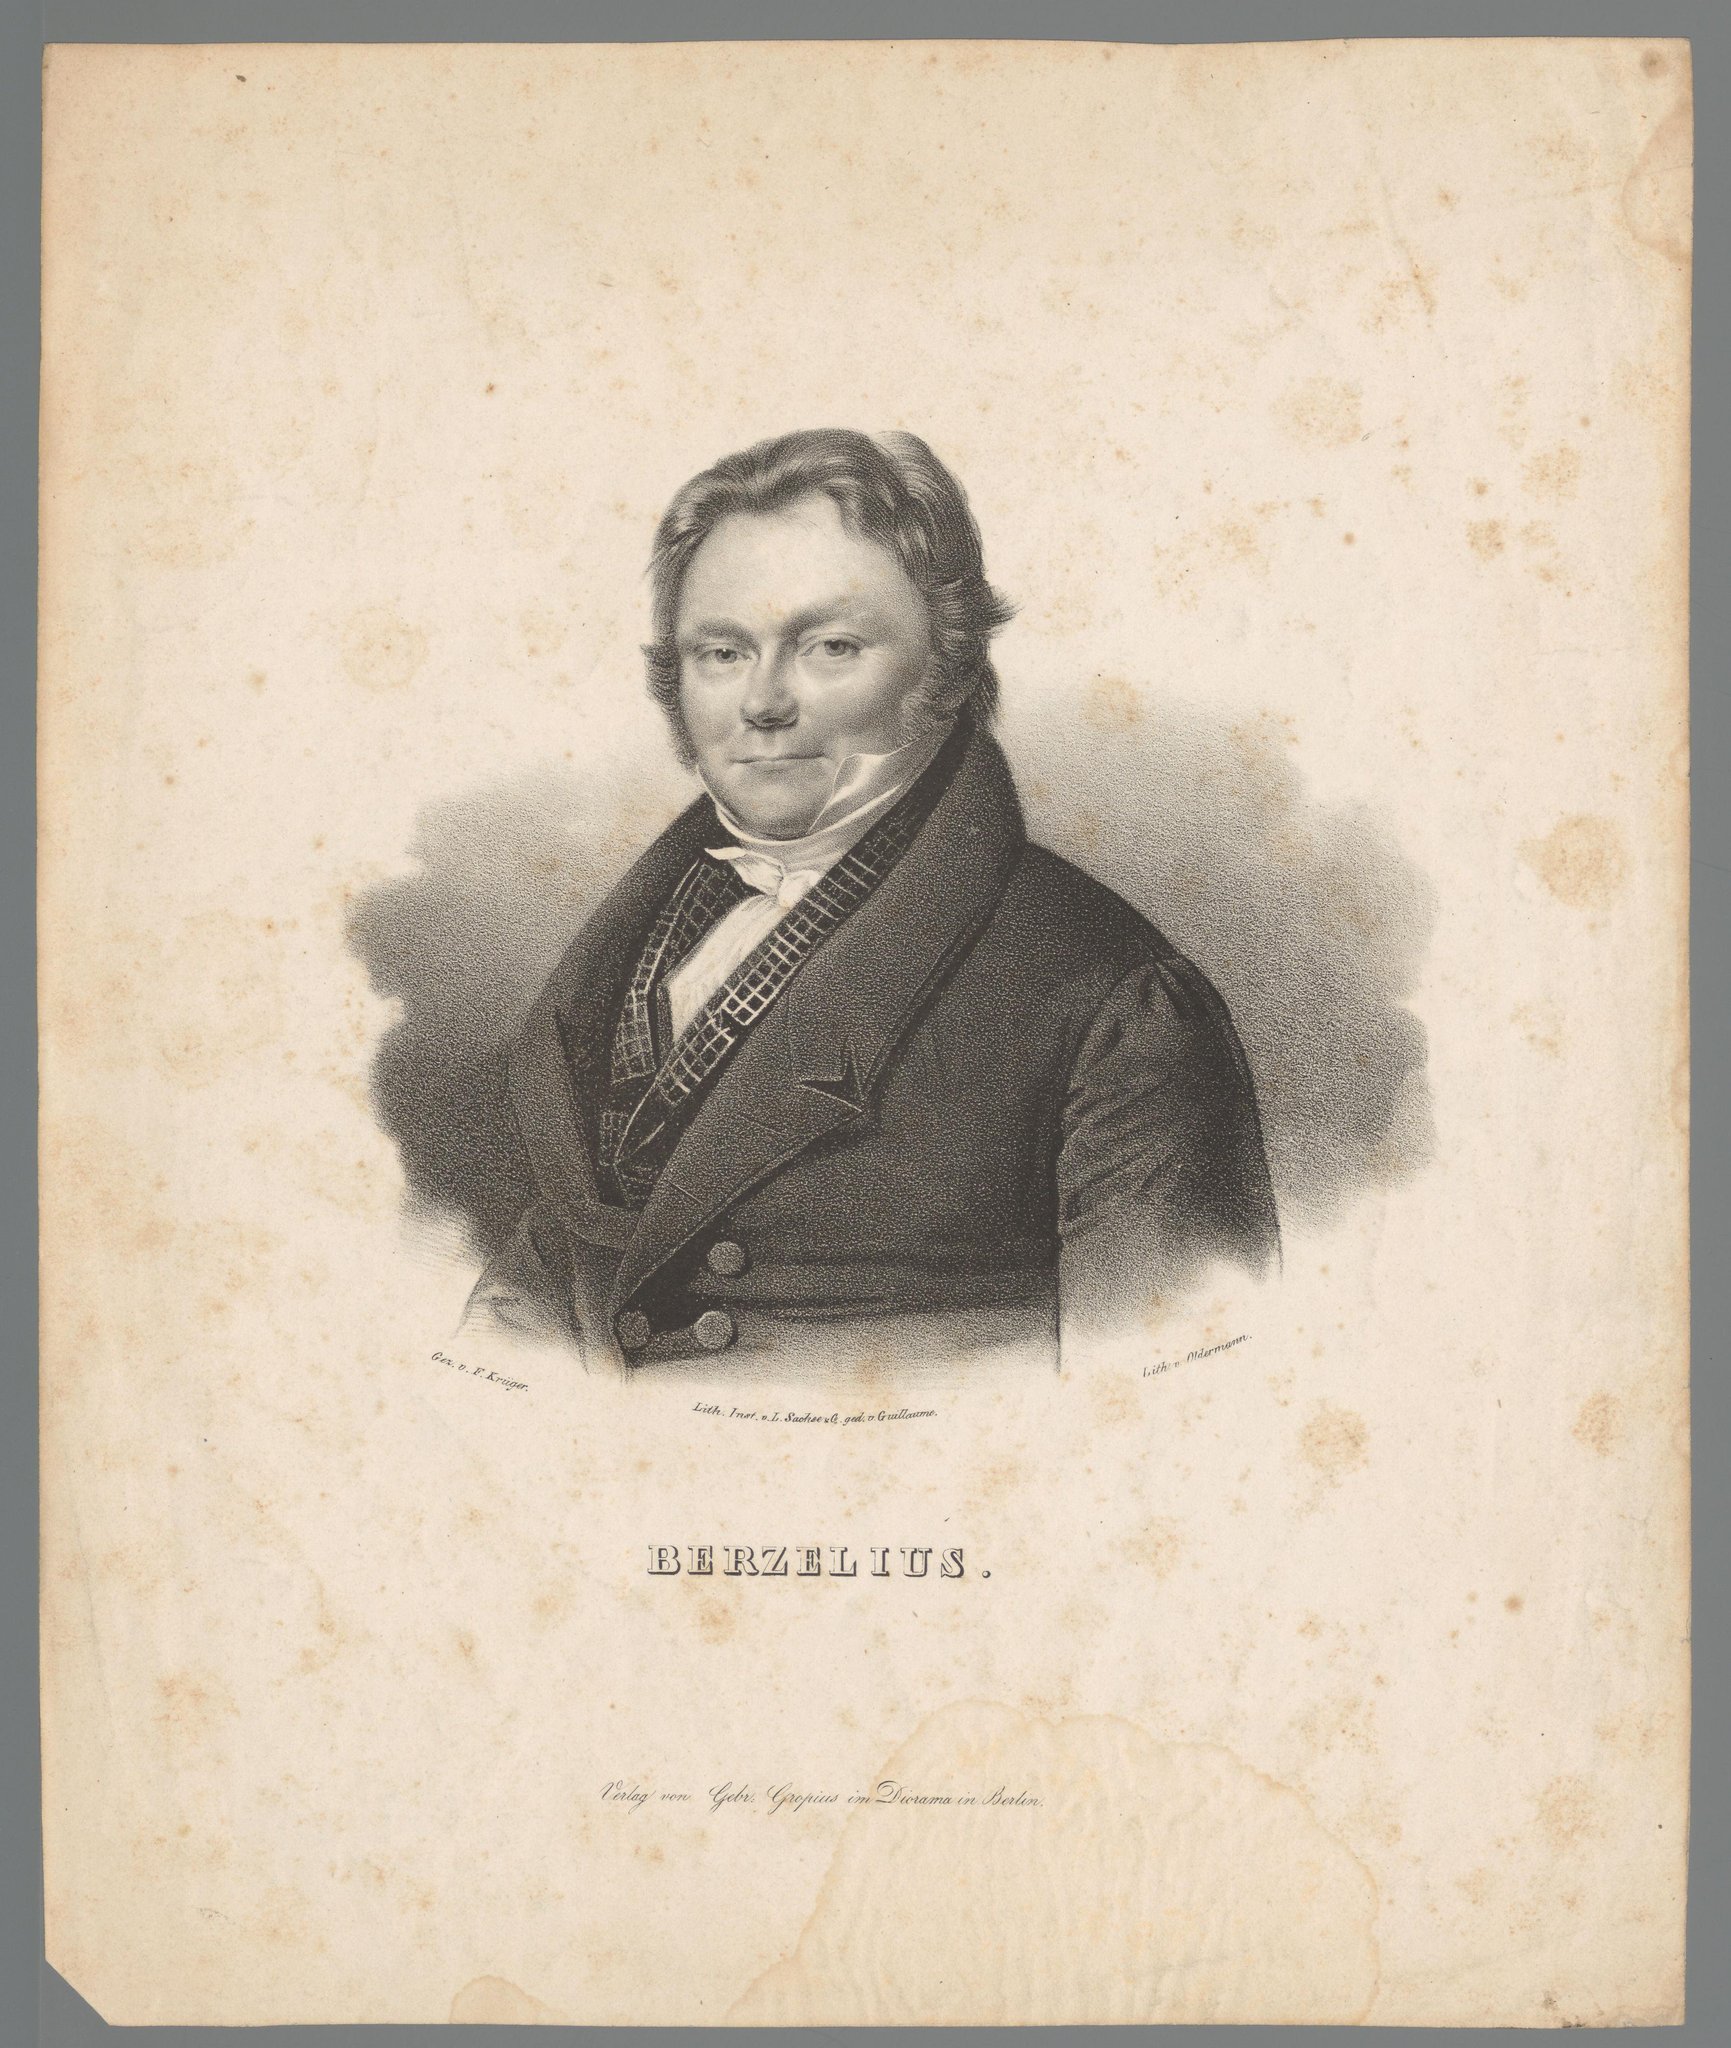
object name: print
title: Berzelius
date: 1812-1874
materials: paper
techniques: lithograph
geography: berlin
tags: chemistry, historical persons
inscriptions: collector's mark: Lugt 2233